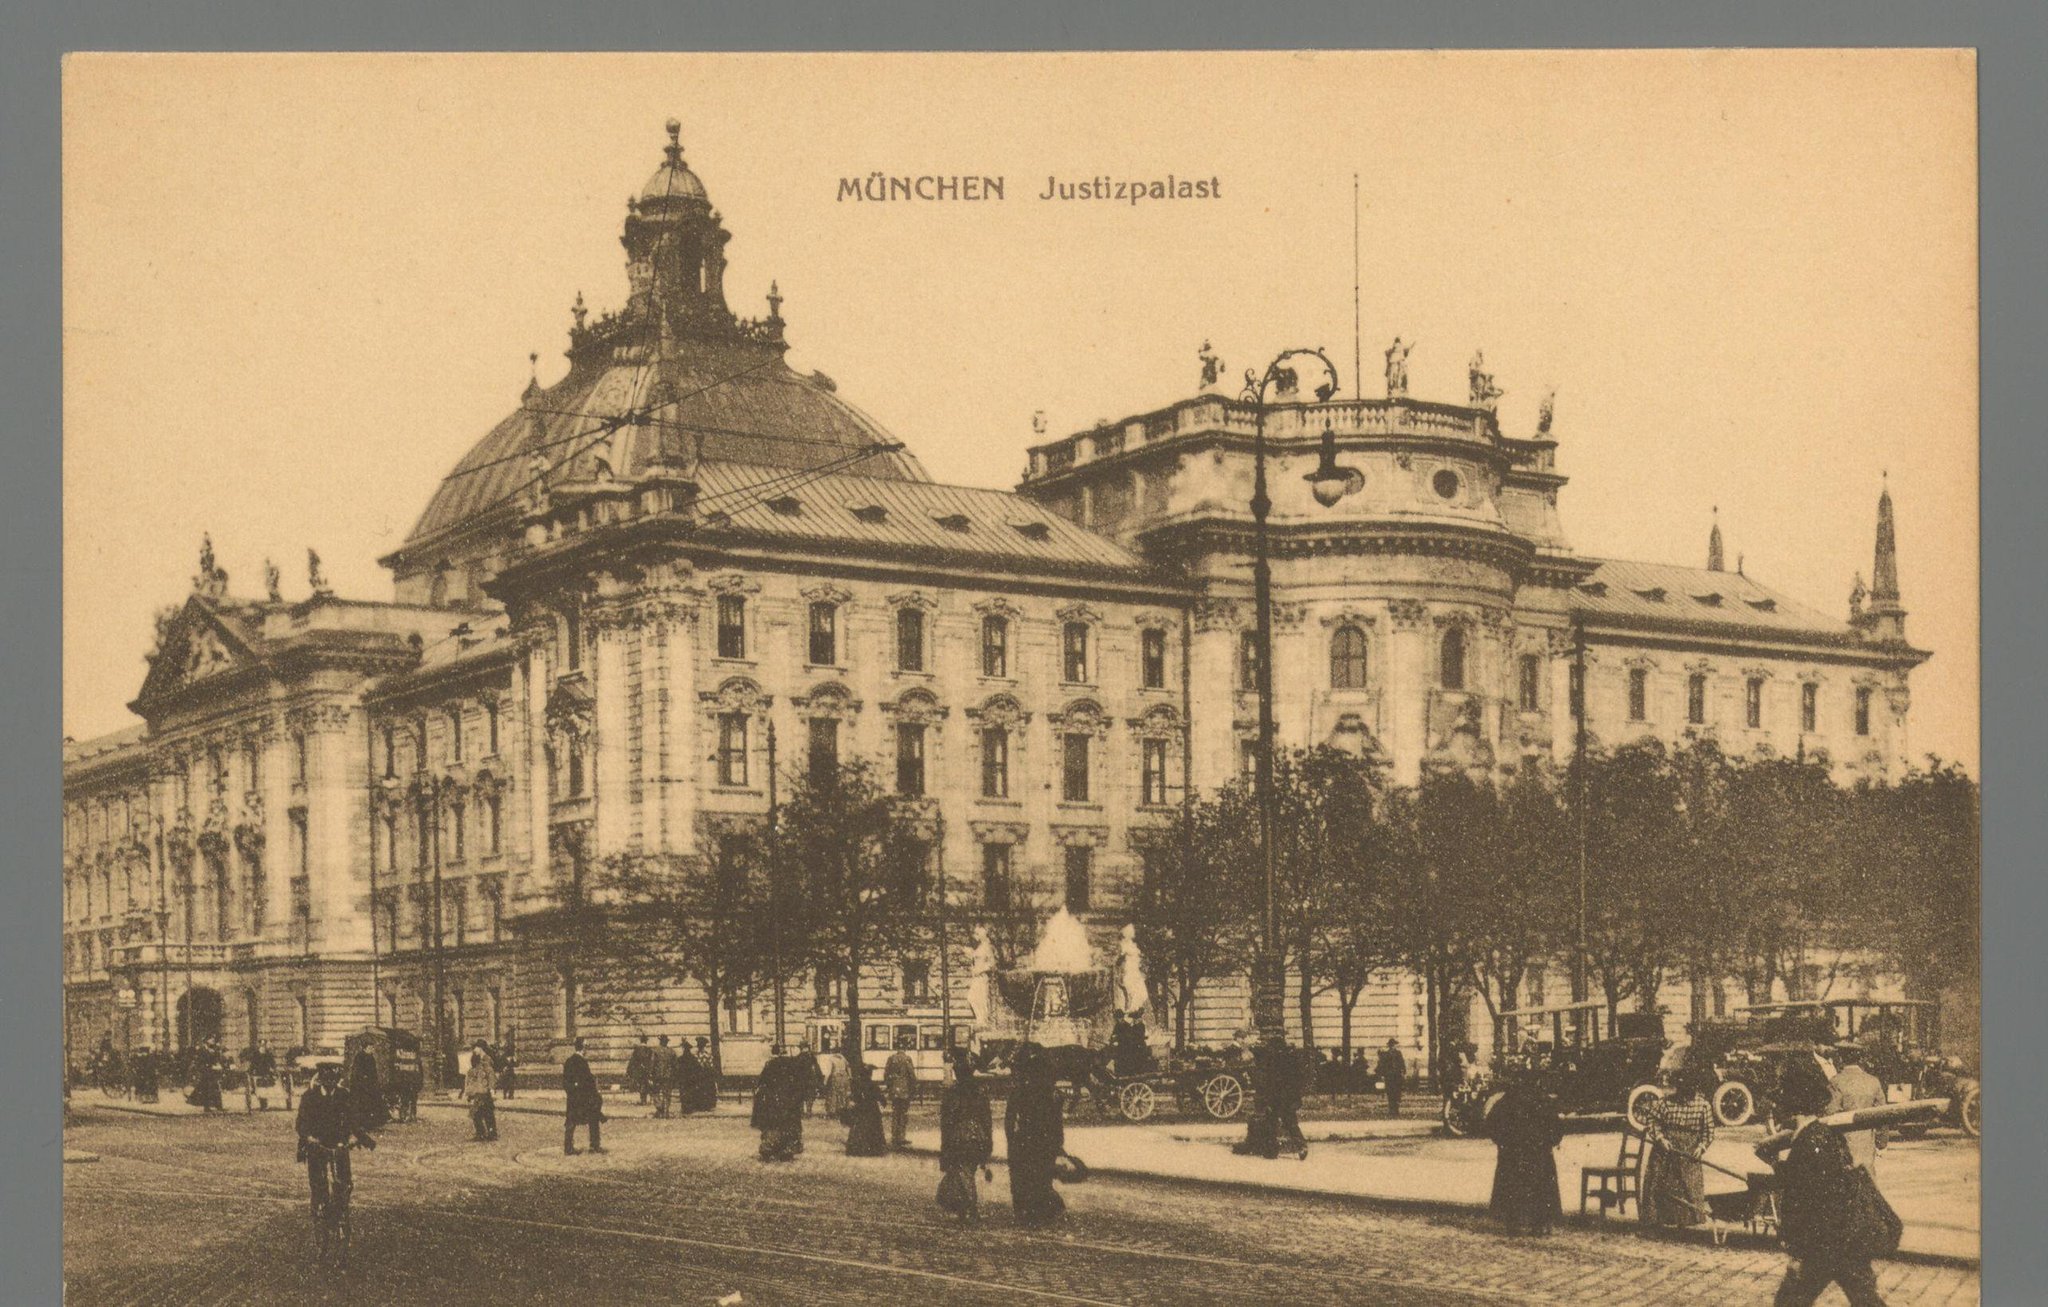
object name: ansichtkaart, prentbriefkaart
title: München. Justizpalast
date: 1905-1909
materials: cardboard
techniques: photograph, writing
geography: munich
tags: court building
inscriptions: inscription: ‘W.H.D.’